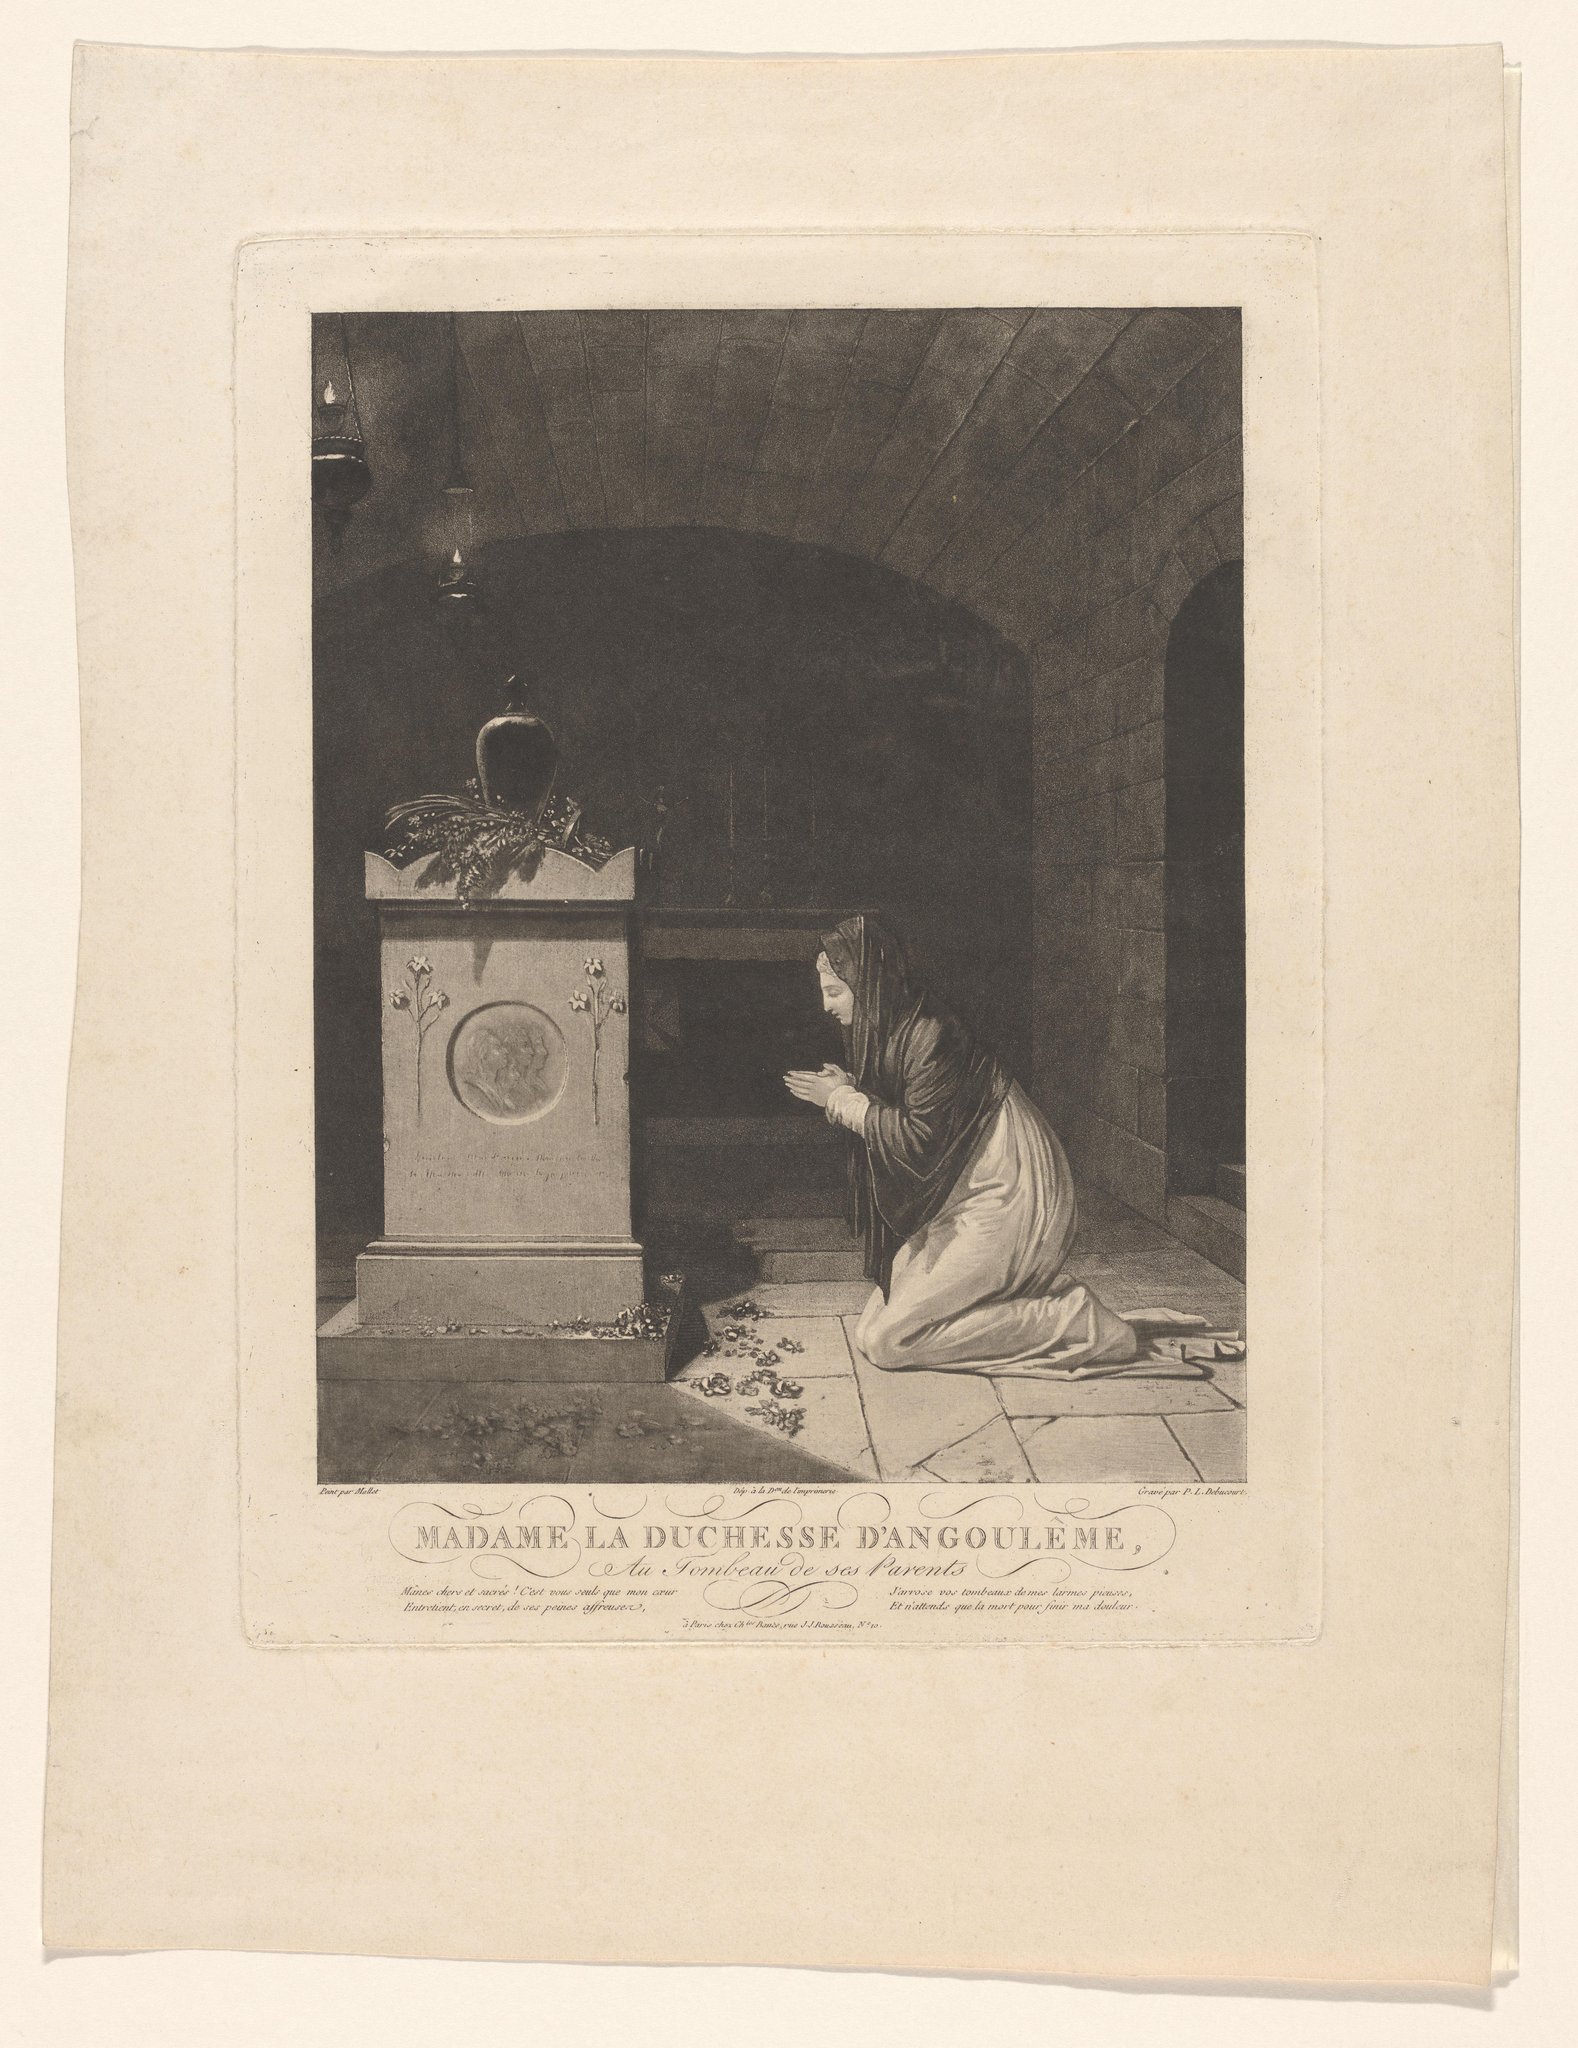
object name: print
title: De hertogin van Angoulême bij het graf van haar ouders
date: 1814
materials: ink, paper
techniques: aquatint, etching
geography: france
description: Op de grond van een crypte knielt de hertogin van Angoulême, Marie Thérèse Charlotte van Frankrijk, voor het grafmonument van haar ouders, Lodewijk XVI en Marie Antoinette. Met vierregelig onderschrift in het Frans.